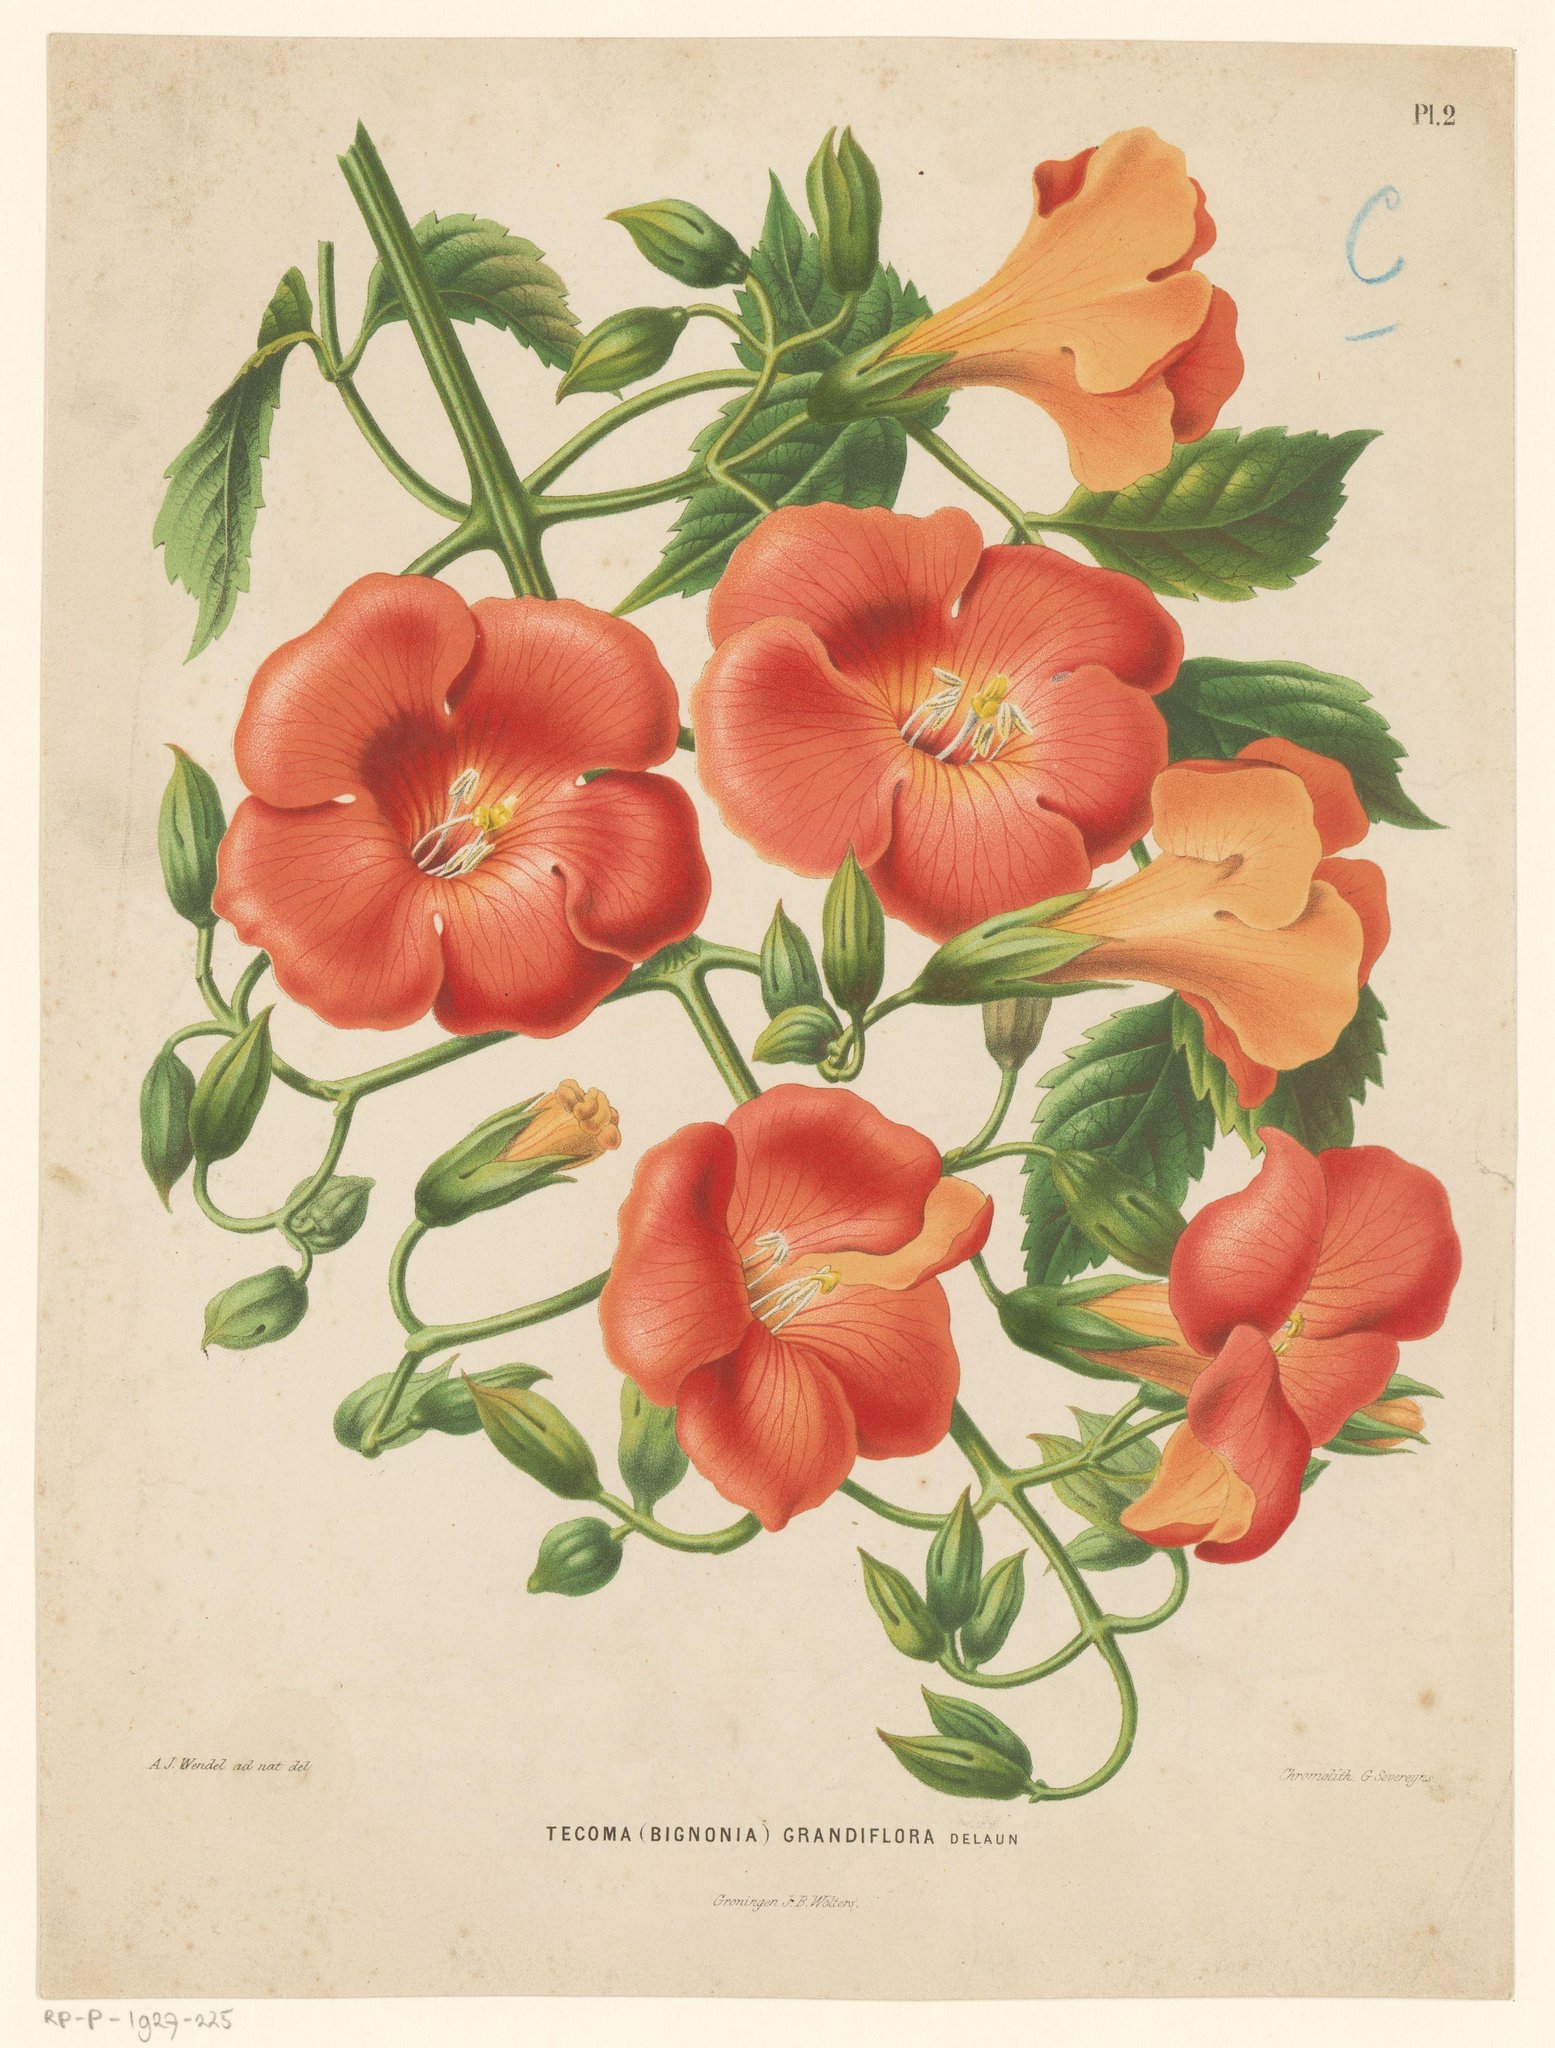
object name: print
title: Tecoma (bignonia) grandiflora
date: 1868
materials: paper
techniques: chromolithography, lithograph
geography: leiden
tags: flowers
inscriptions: collector's mark: Lugt 2228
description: Deze prent is afkomstig uit: Flora. Heinrich Witte, Afbeeldingen en beschrijvingen van boomen, heesters, éénjarige planten, enz., voorkomende in de Nederlandsche tuinen. Groningen: J.B. Wolters, 1868.